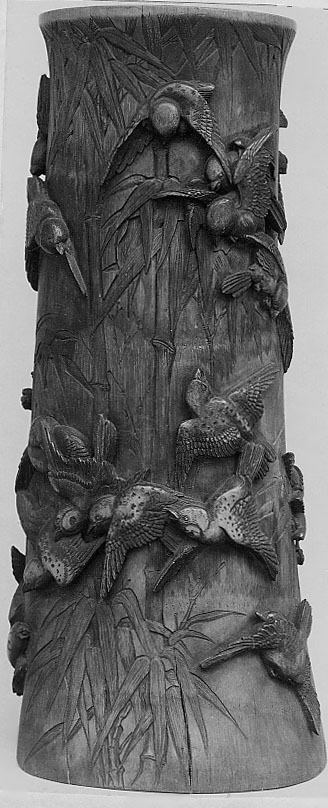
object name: vase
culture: japanese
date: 1801-1900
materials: bamboo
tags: leaves